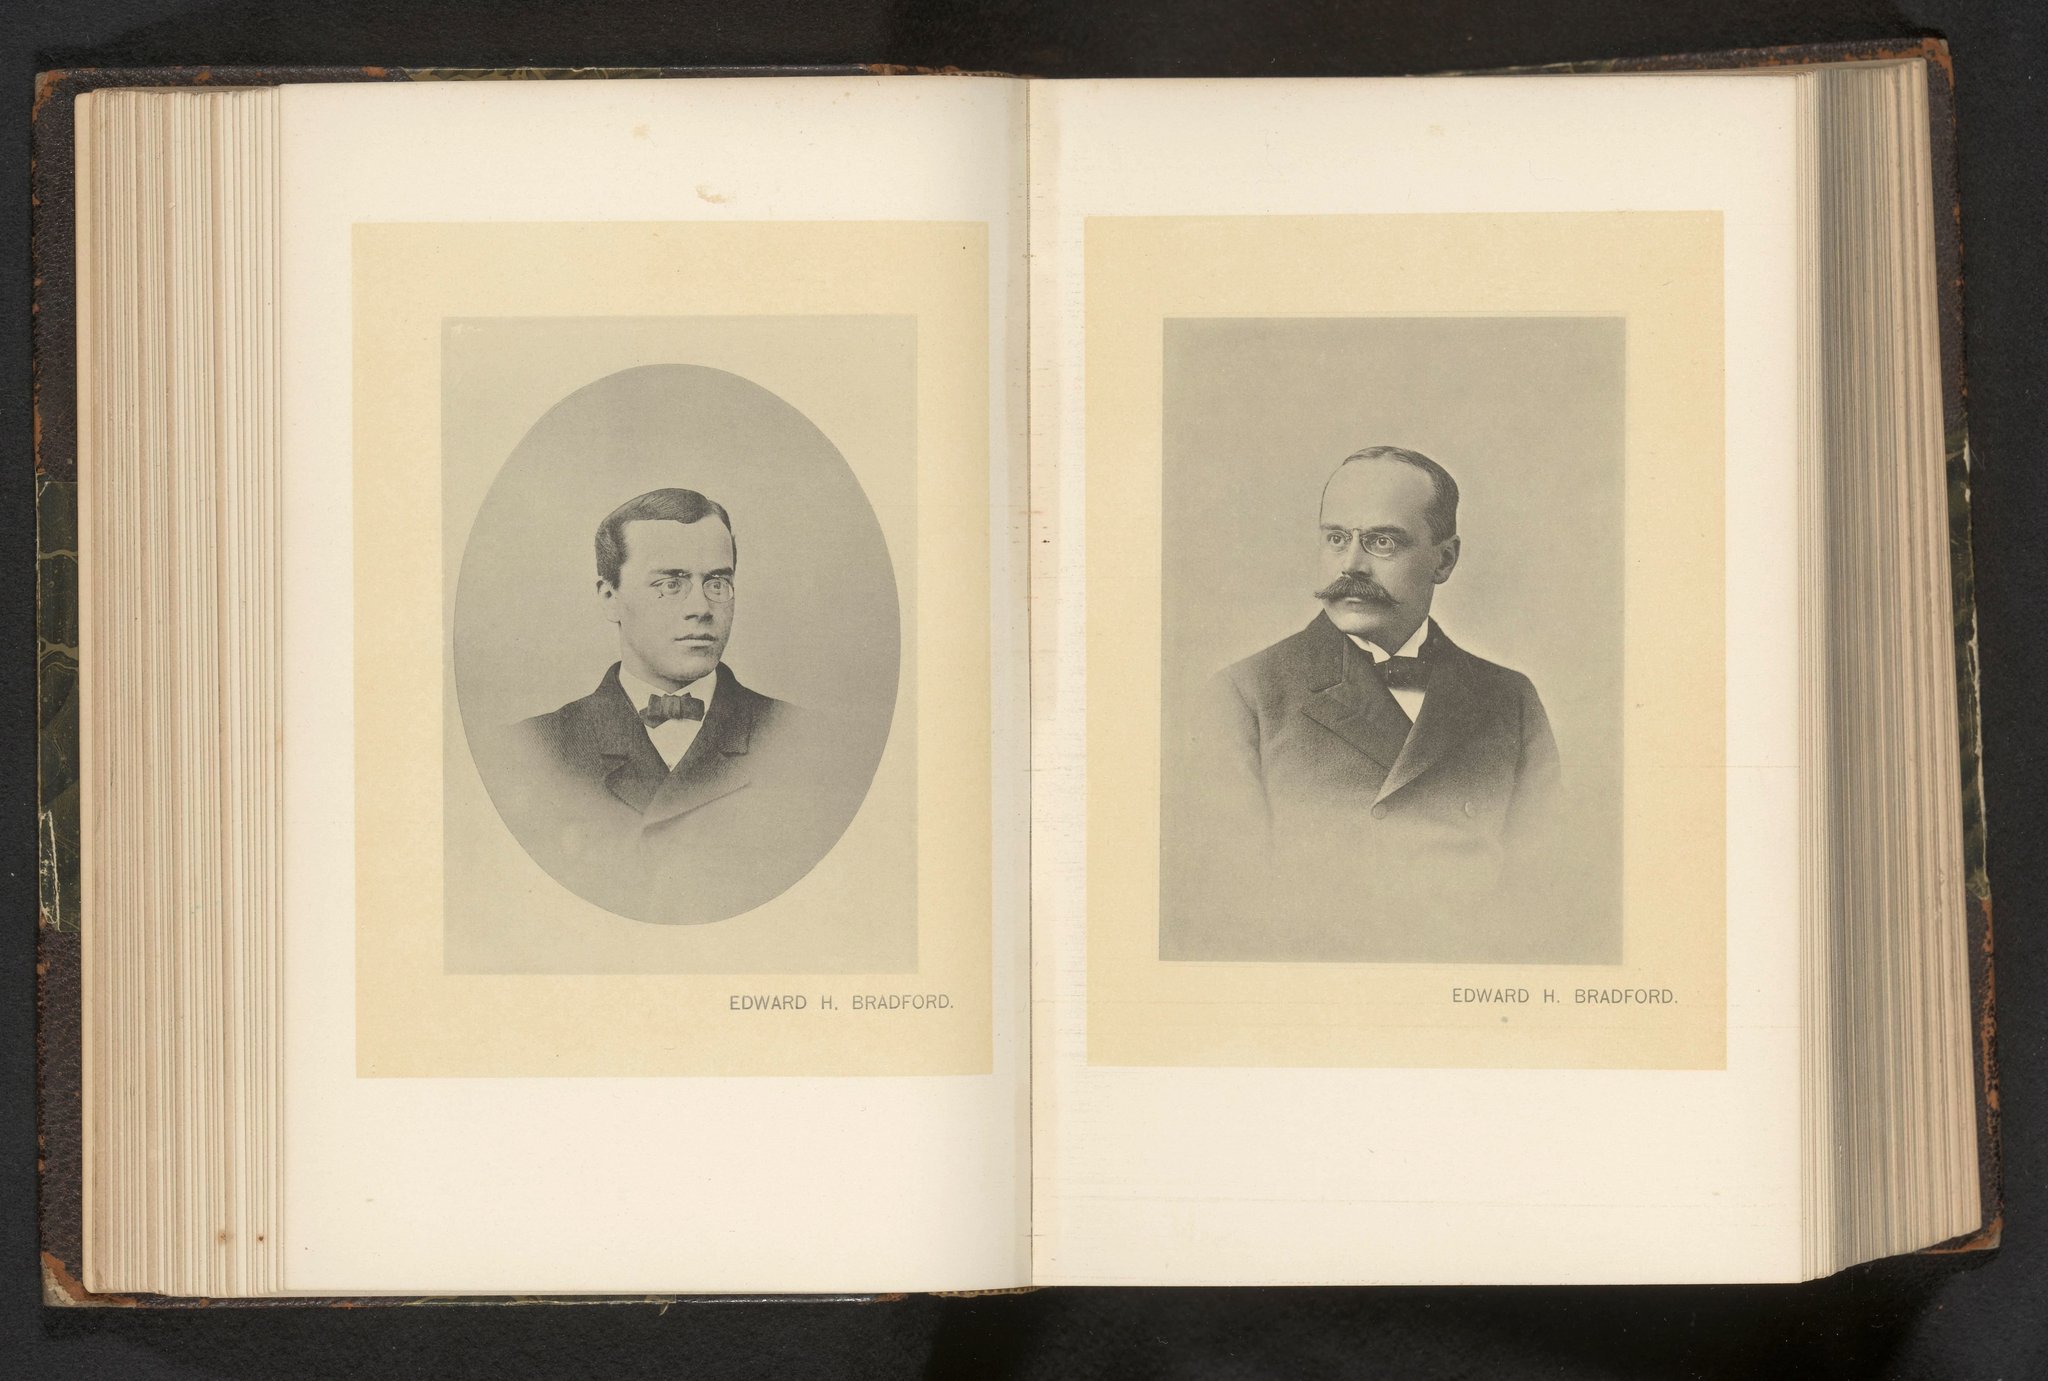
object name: page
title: Edward H. Bradford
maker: Anonymous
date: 1869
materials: paper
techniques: photoaquatint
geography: boston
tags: adult man